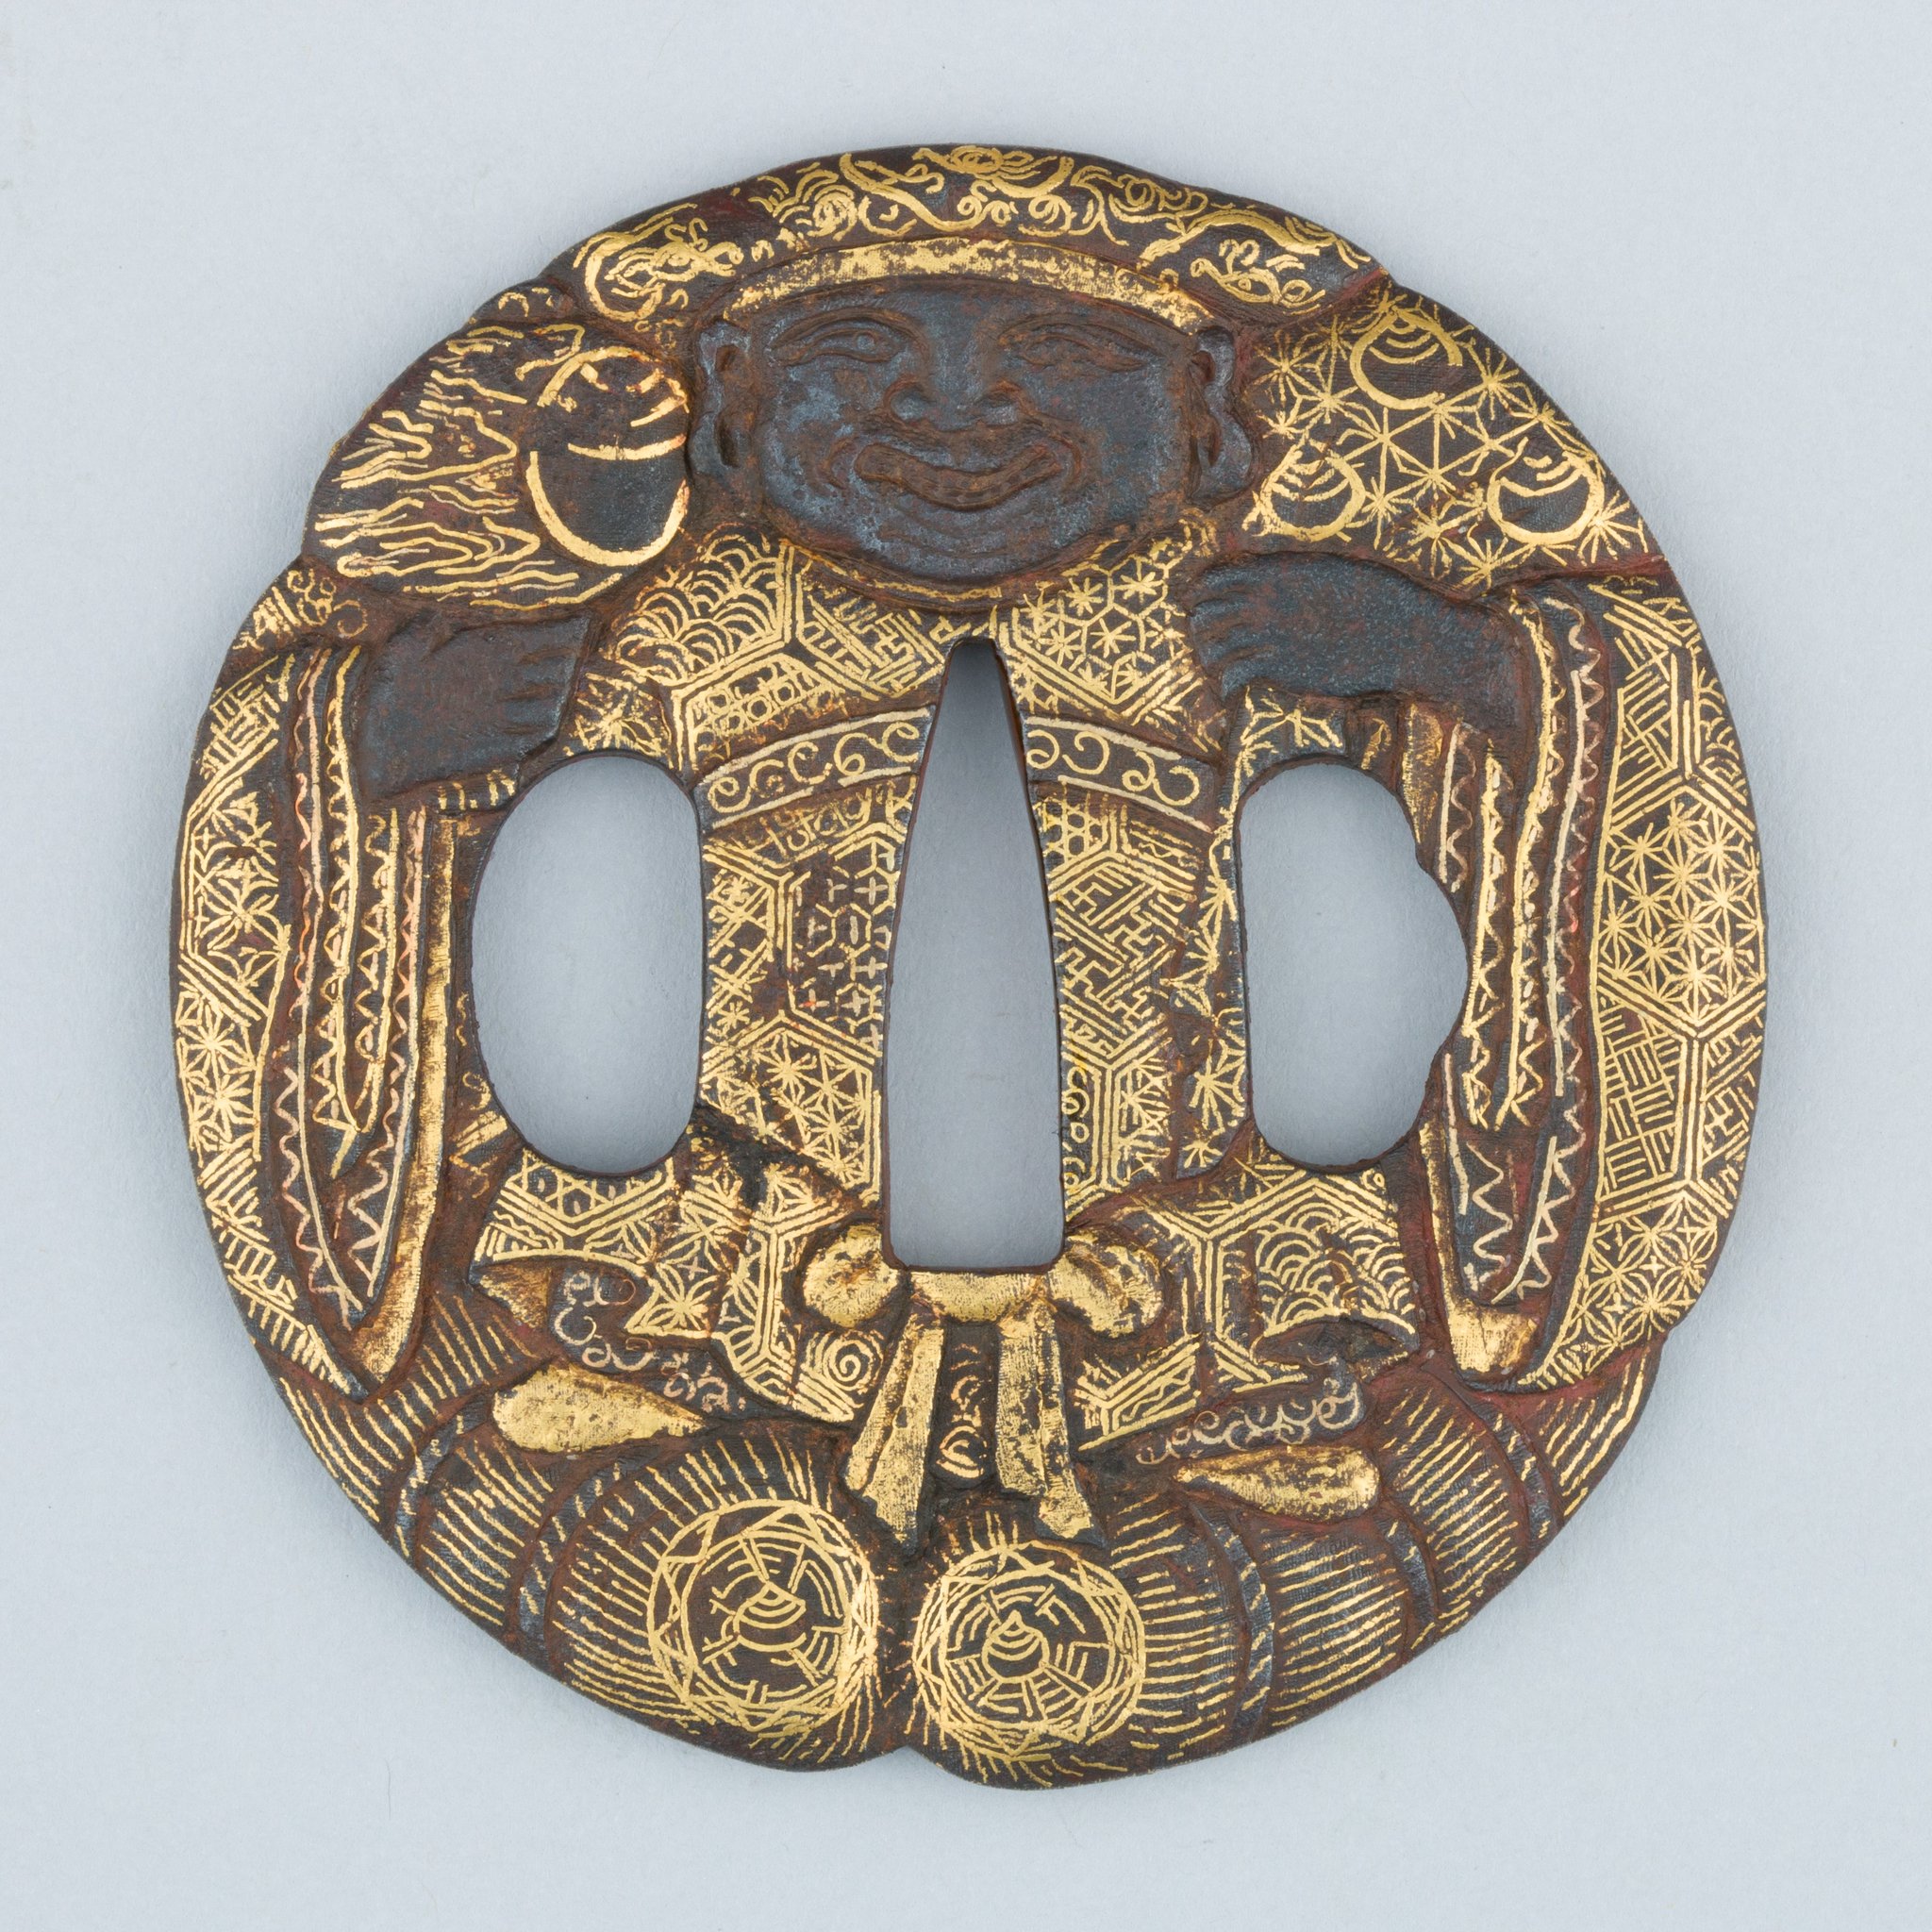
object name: sword guard tsuba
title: Sword Guard (Tsuba)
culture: japanese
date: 1701-1800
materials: copper, gold, iron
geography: japan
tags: men